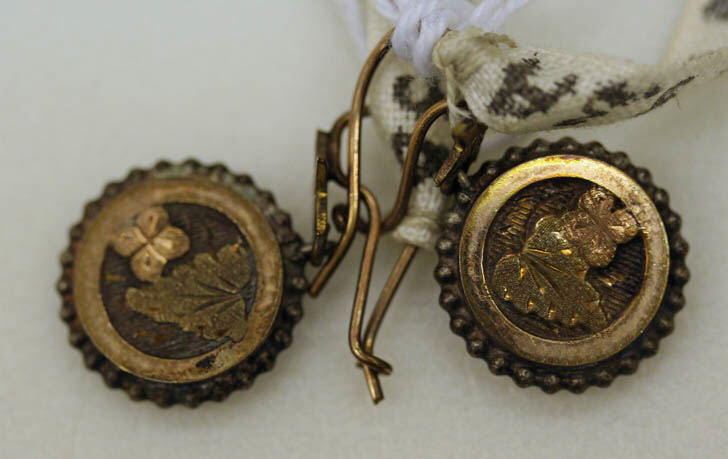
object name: earring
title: Earrings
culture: american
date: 1870-1890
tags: leaves